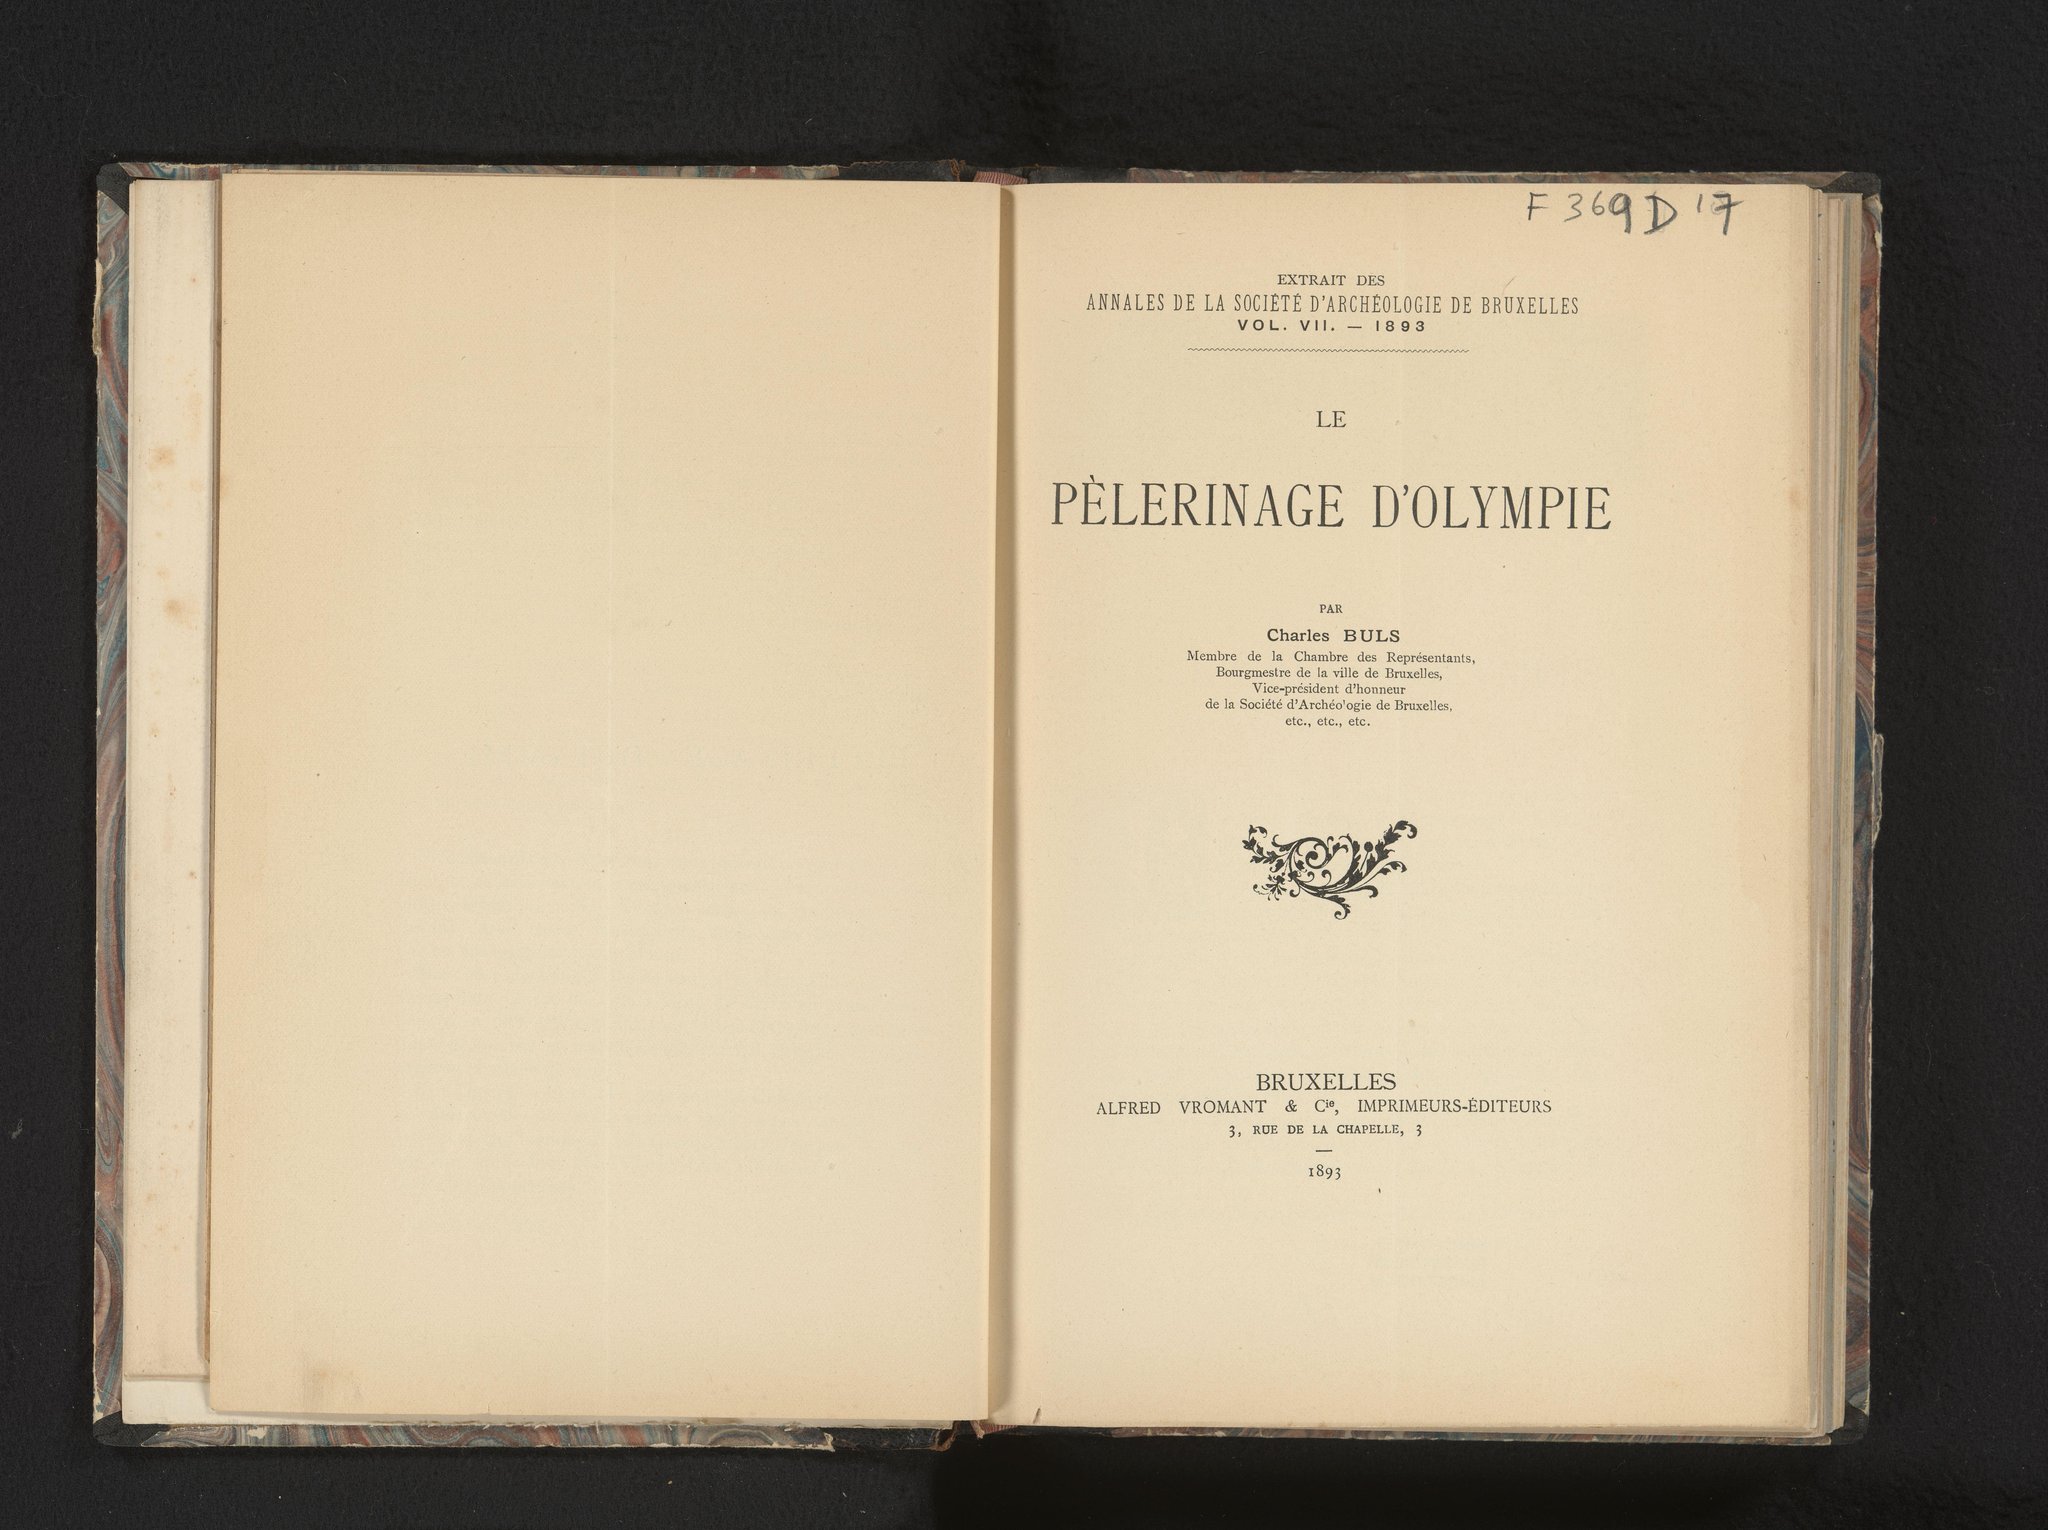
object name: book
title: Le pèlerinage d'Olympie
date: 1893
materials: linen, paper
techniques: printing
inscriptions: number: ‘2.000-’, bookplate: ‘Comtede Kerchove de Denterghem’, date: ‘Jan 1992’